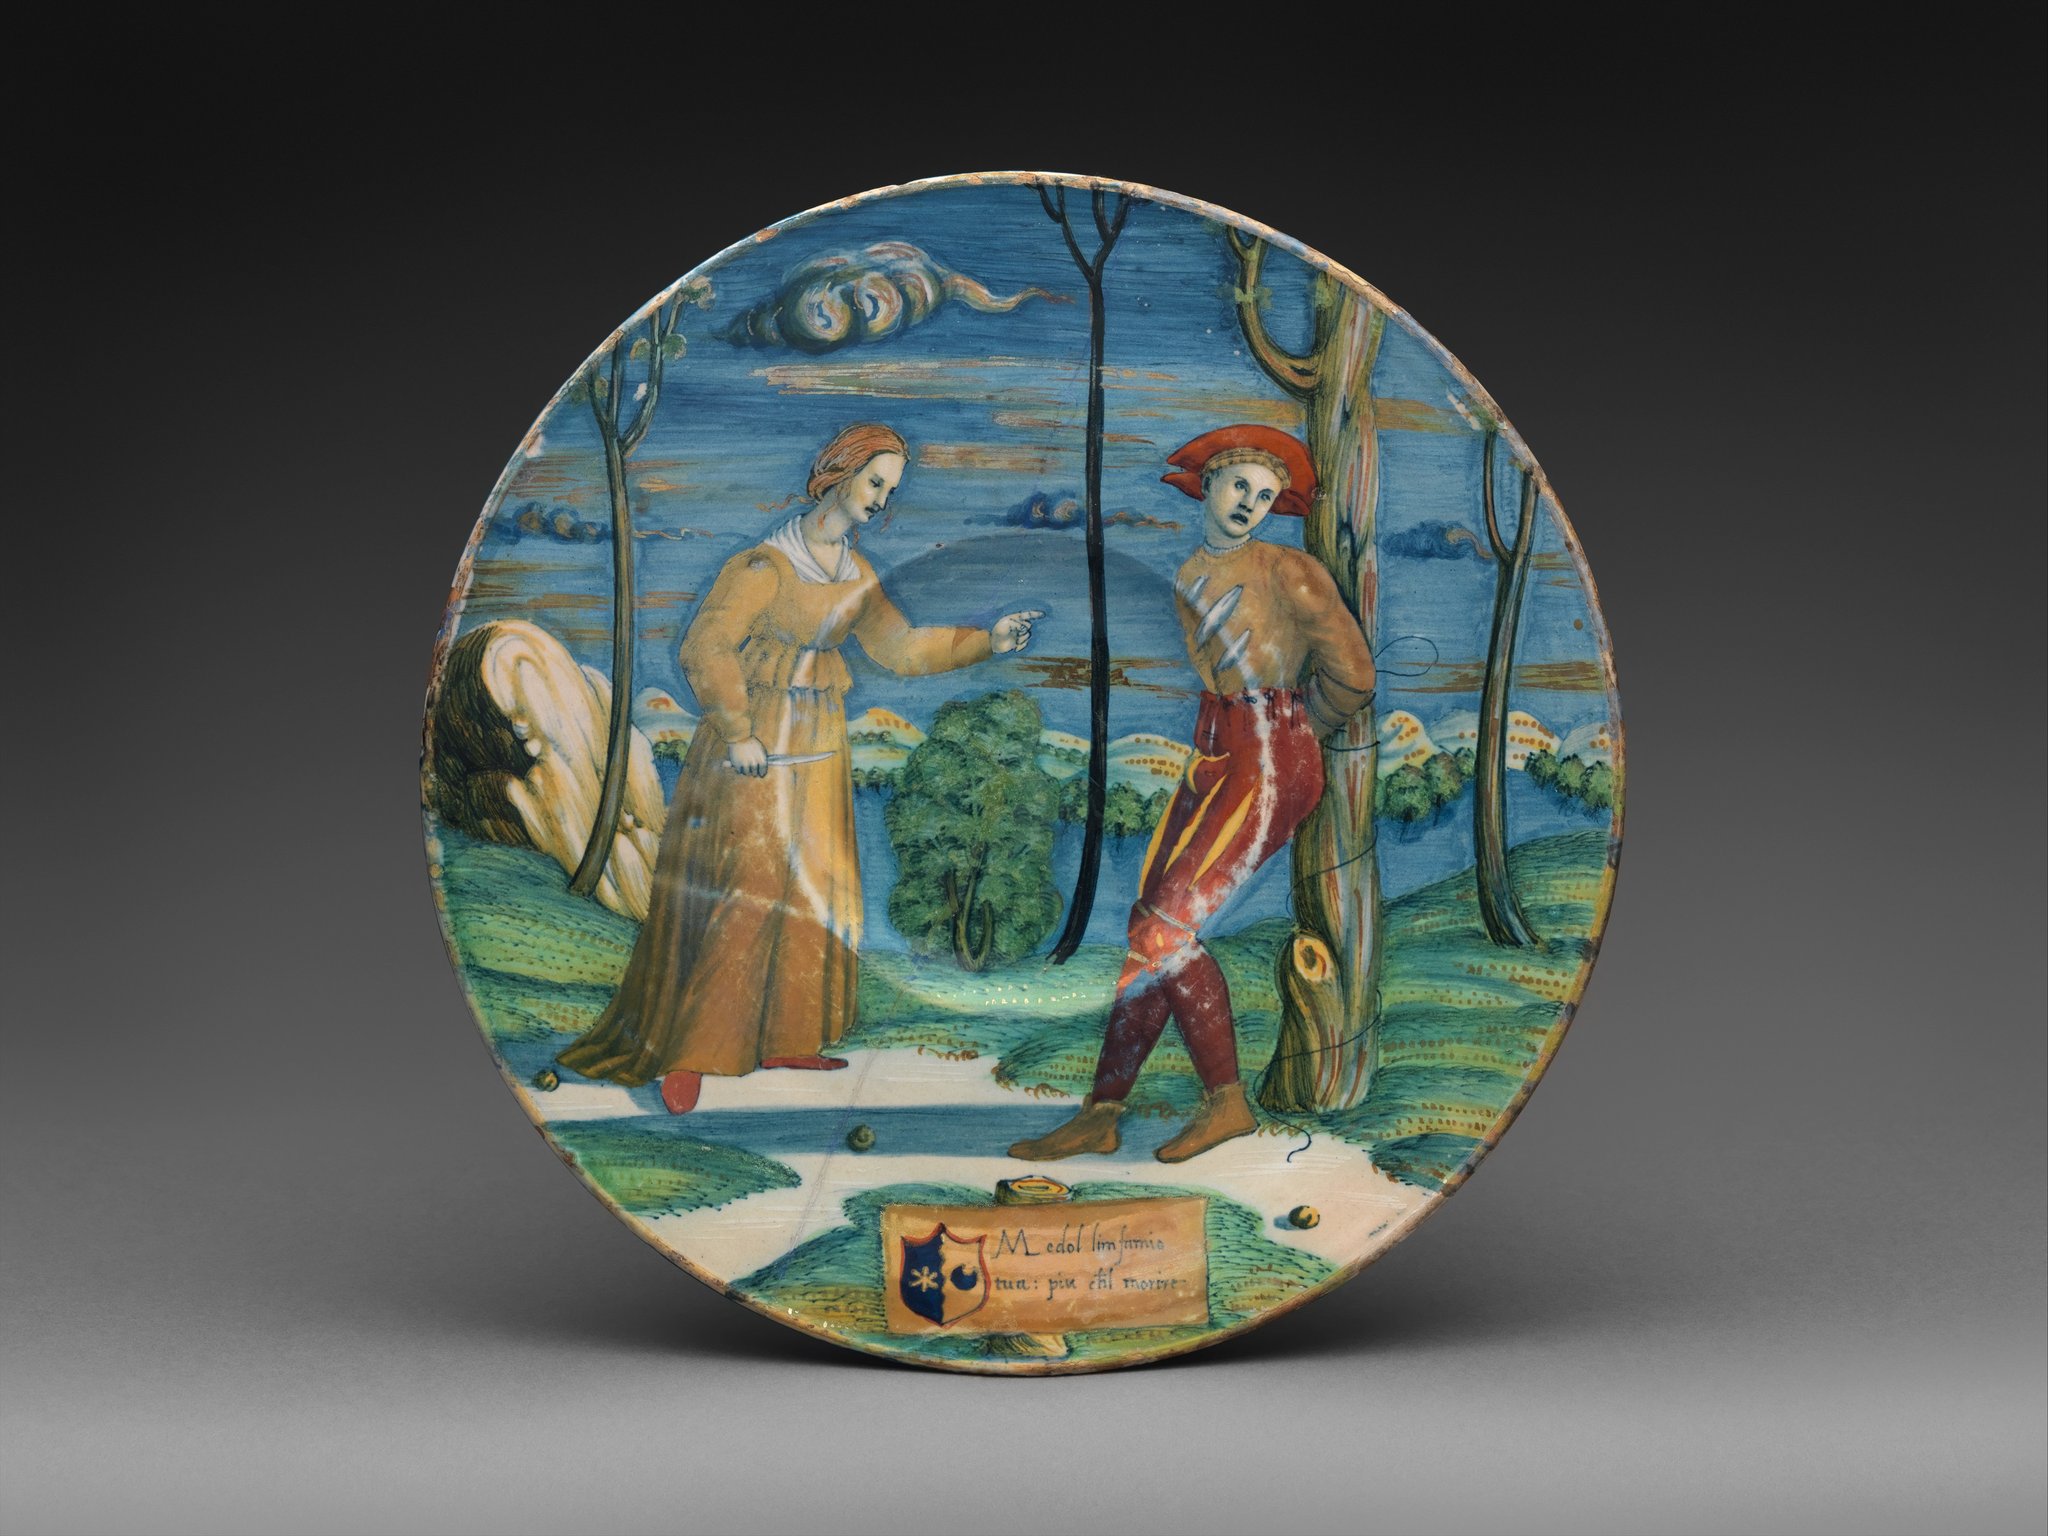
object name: plate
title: Plate with The Lover Tormented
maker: maestro giorgio andreoli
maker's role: artist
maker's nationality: italian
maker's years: 1500-1550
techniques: maiolica, glazing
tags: men,lovers,women,trees